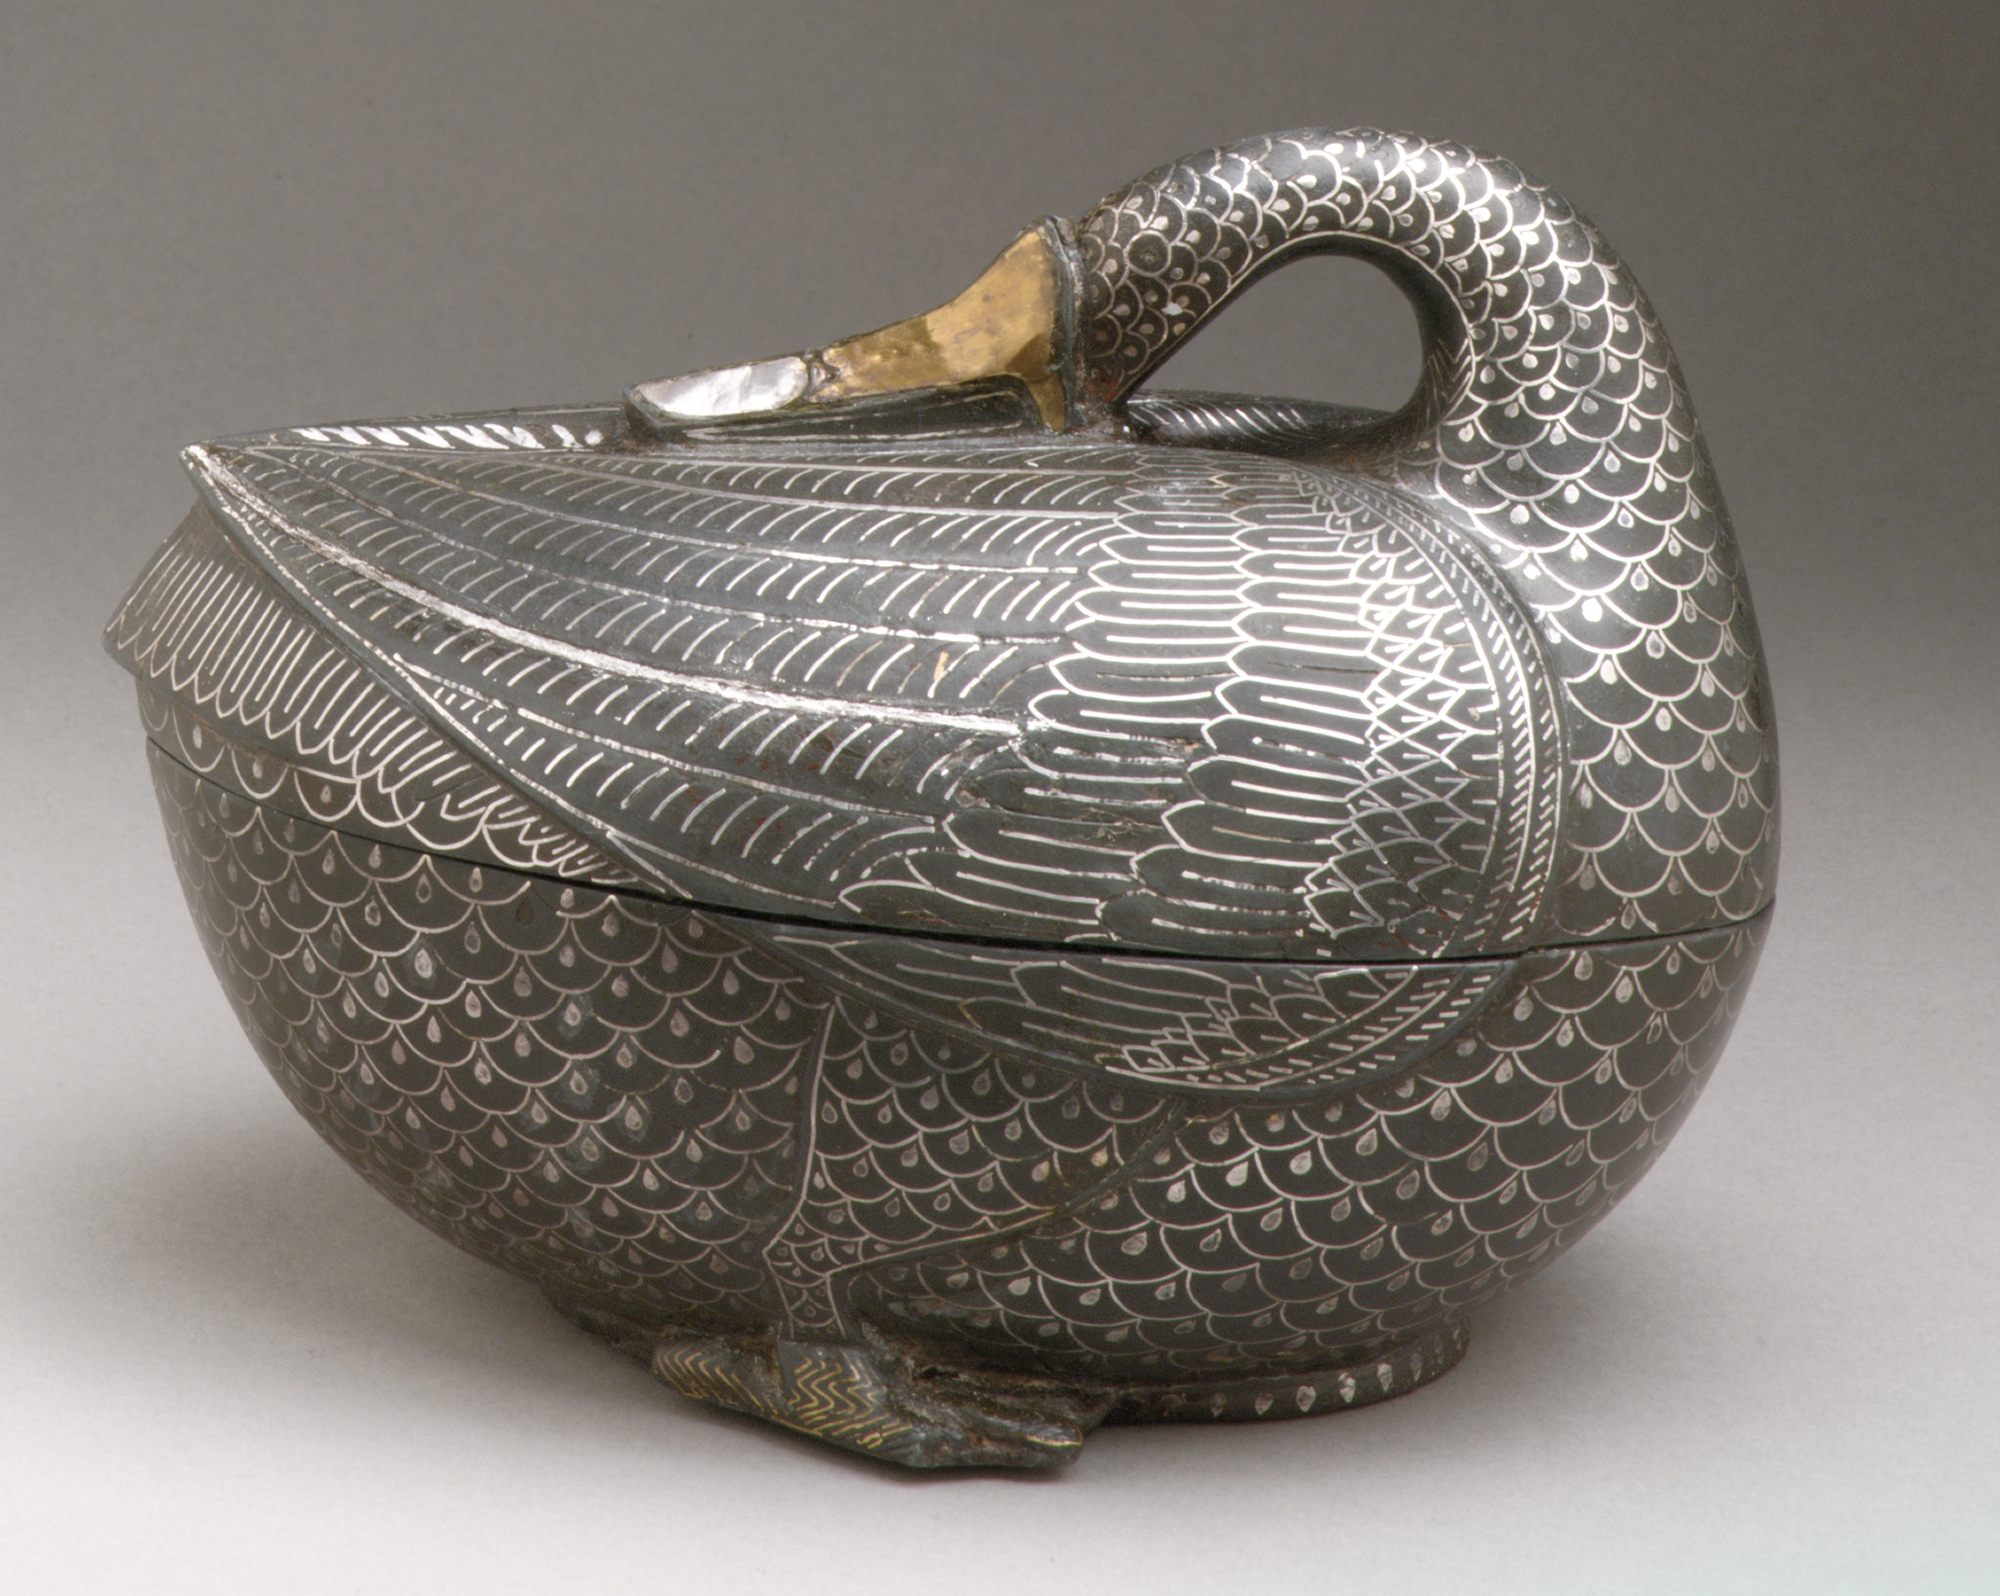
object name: pan box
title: Pan Box in the Shape of a Duck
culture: indian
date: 1700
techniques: inlay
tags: ducks